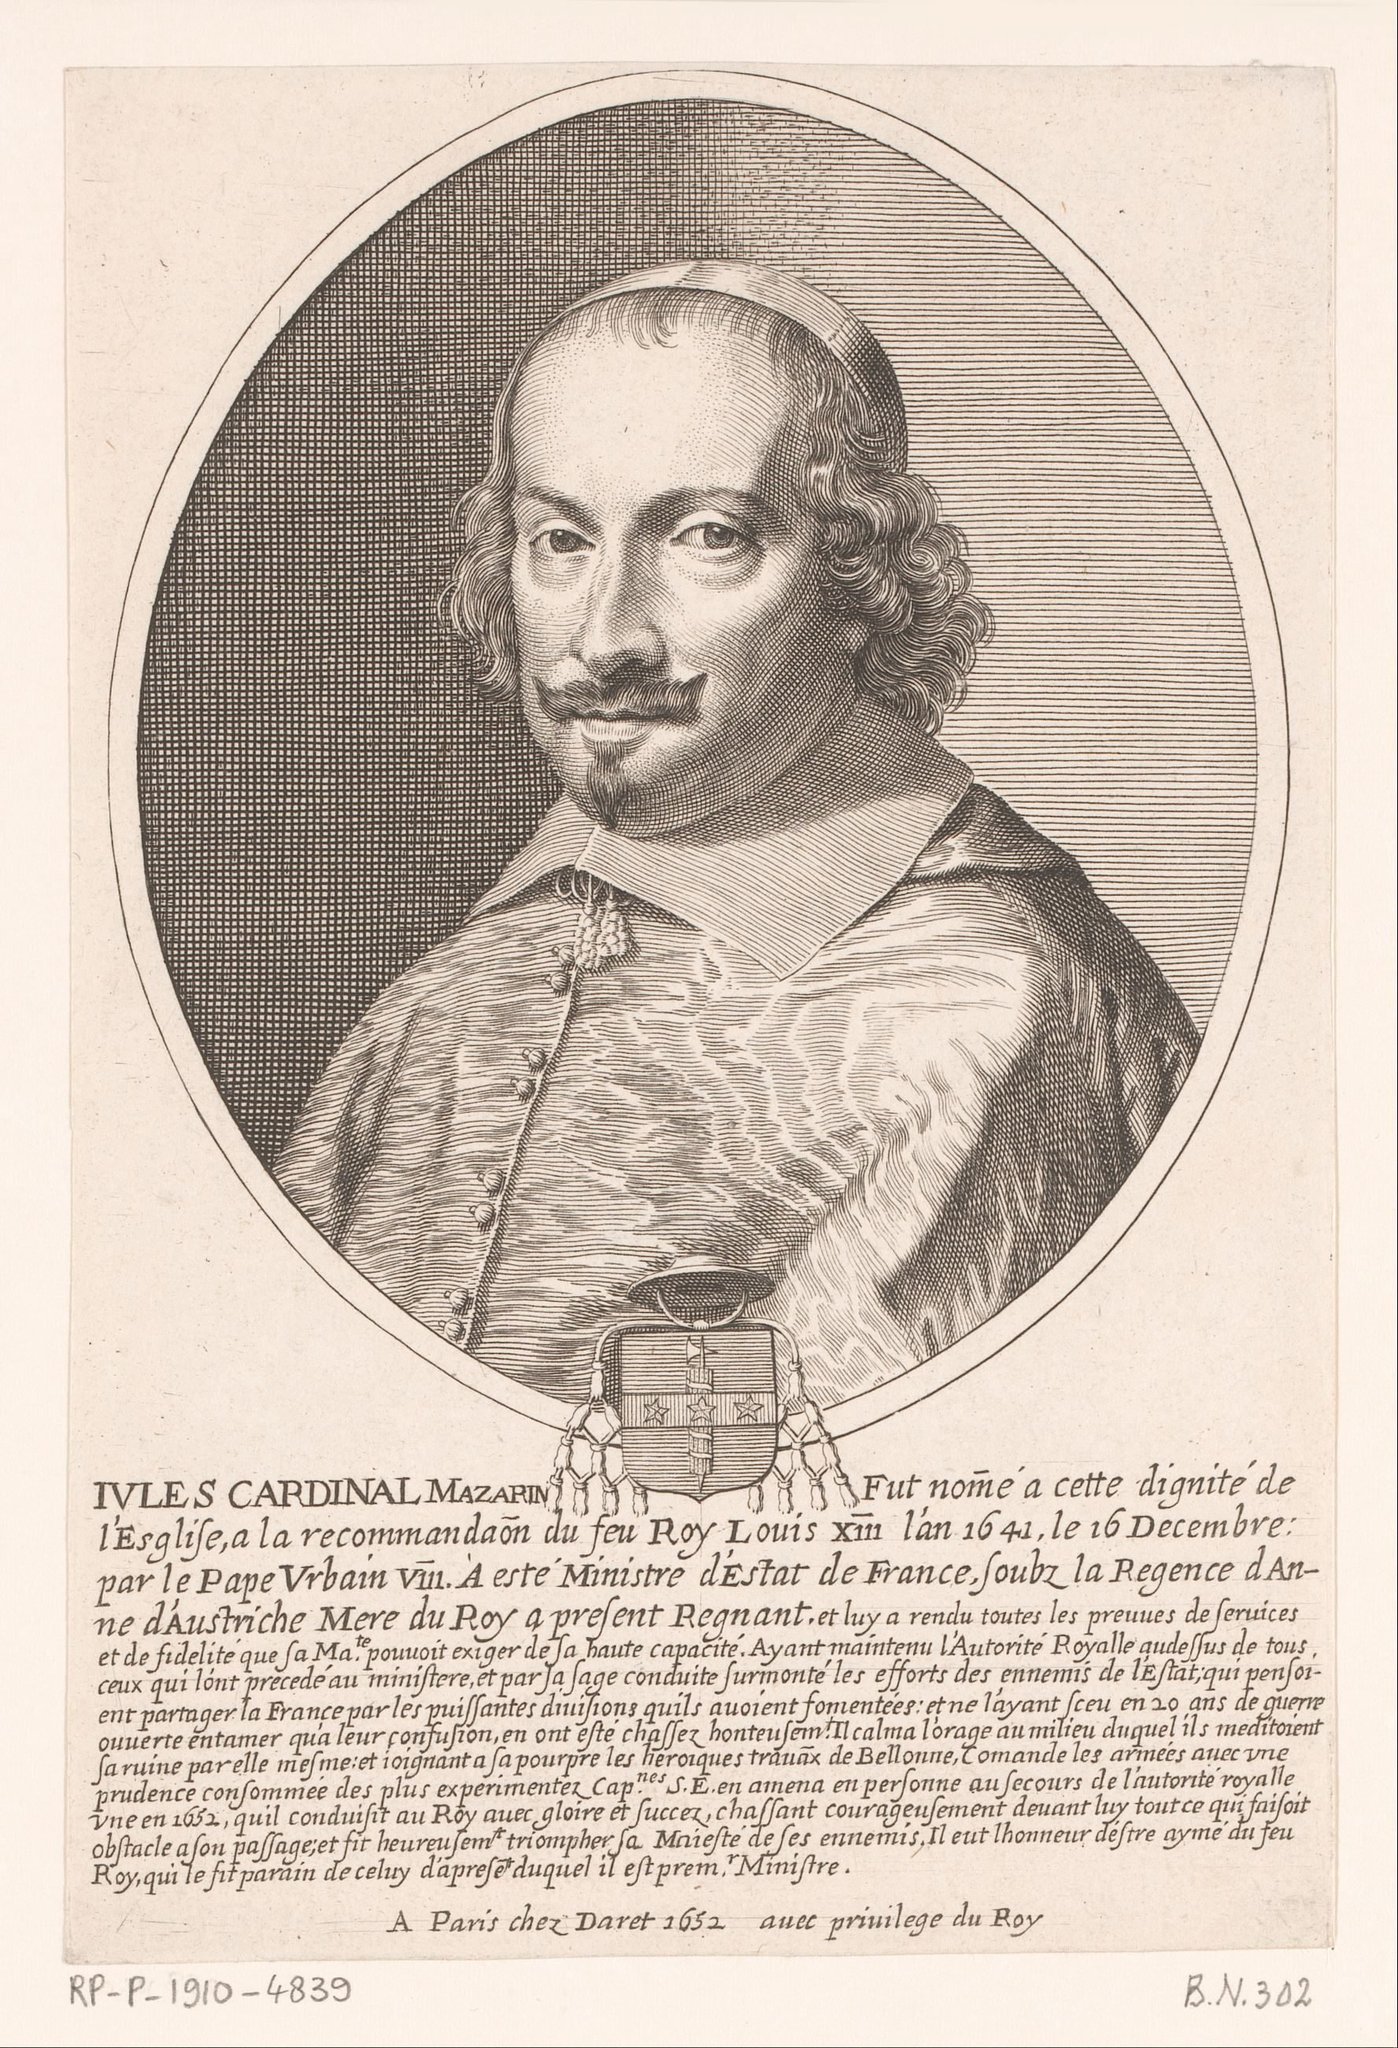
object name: print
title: Portret van Jules Mazarin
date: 1652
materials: paper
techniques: engraving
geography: paris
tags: jules mazarin, cardinal, historical persons, armorial bearing, heraldry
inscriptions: collector's mark: Lugt 2228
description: Maakt deel uit van een serie portretten getiteld 'Tableaux historiques ou sont gravez les Illustres François et Etrangiers de l'un et l'autre sexe (...)', voor het eerst uitgegeven in 1652 door Daret. Een tweede staat werd uitgegeven door Boissevin en een derde door Jollain.